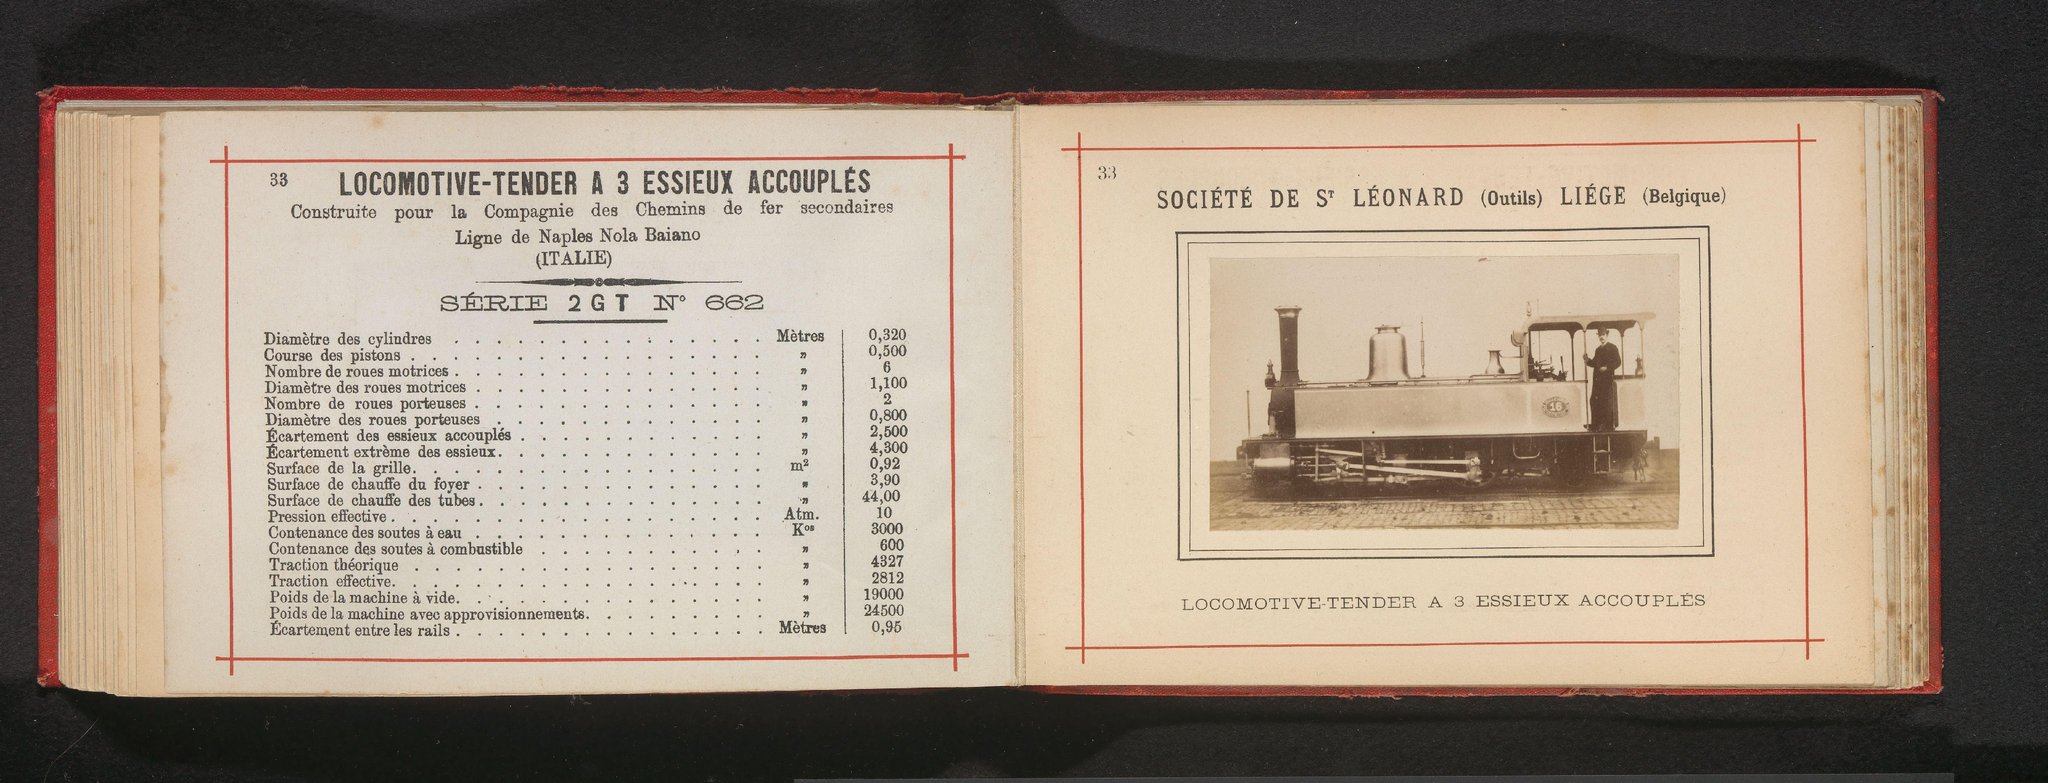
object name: photograph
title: Locomotive-tender a 3 essieux accouplés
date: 1880-1885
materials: photographic support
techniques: albumen print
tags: locomotive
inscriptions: inscription: ‘Société de St. Léonard (Outils) Liége (Belgique)’